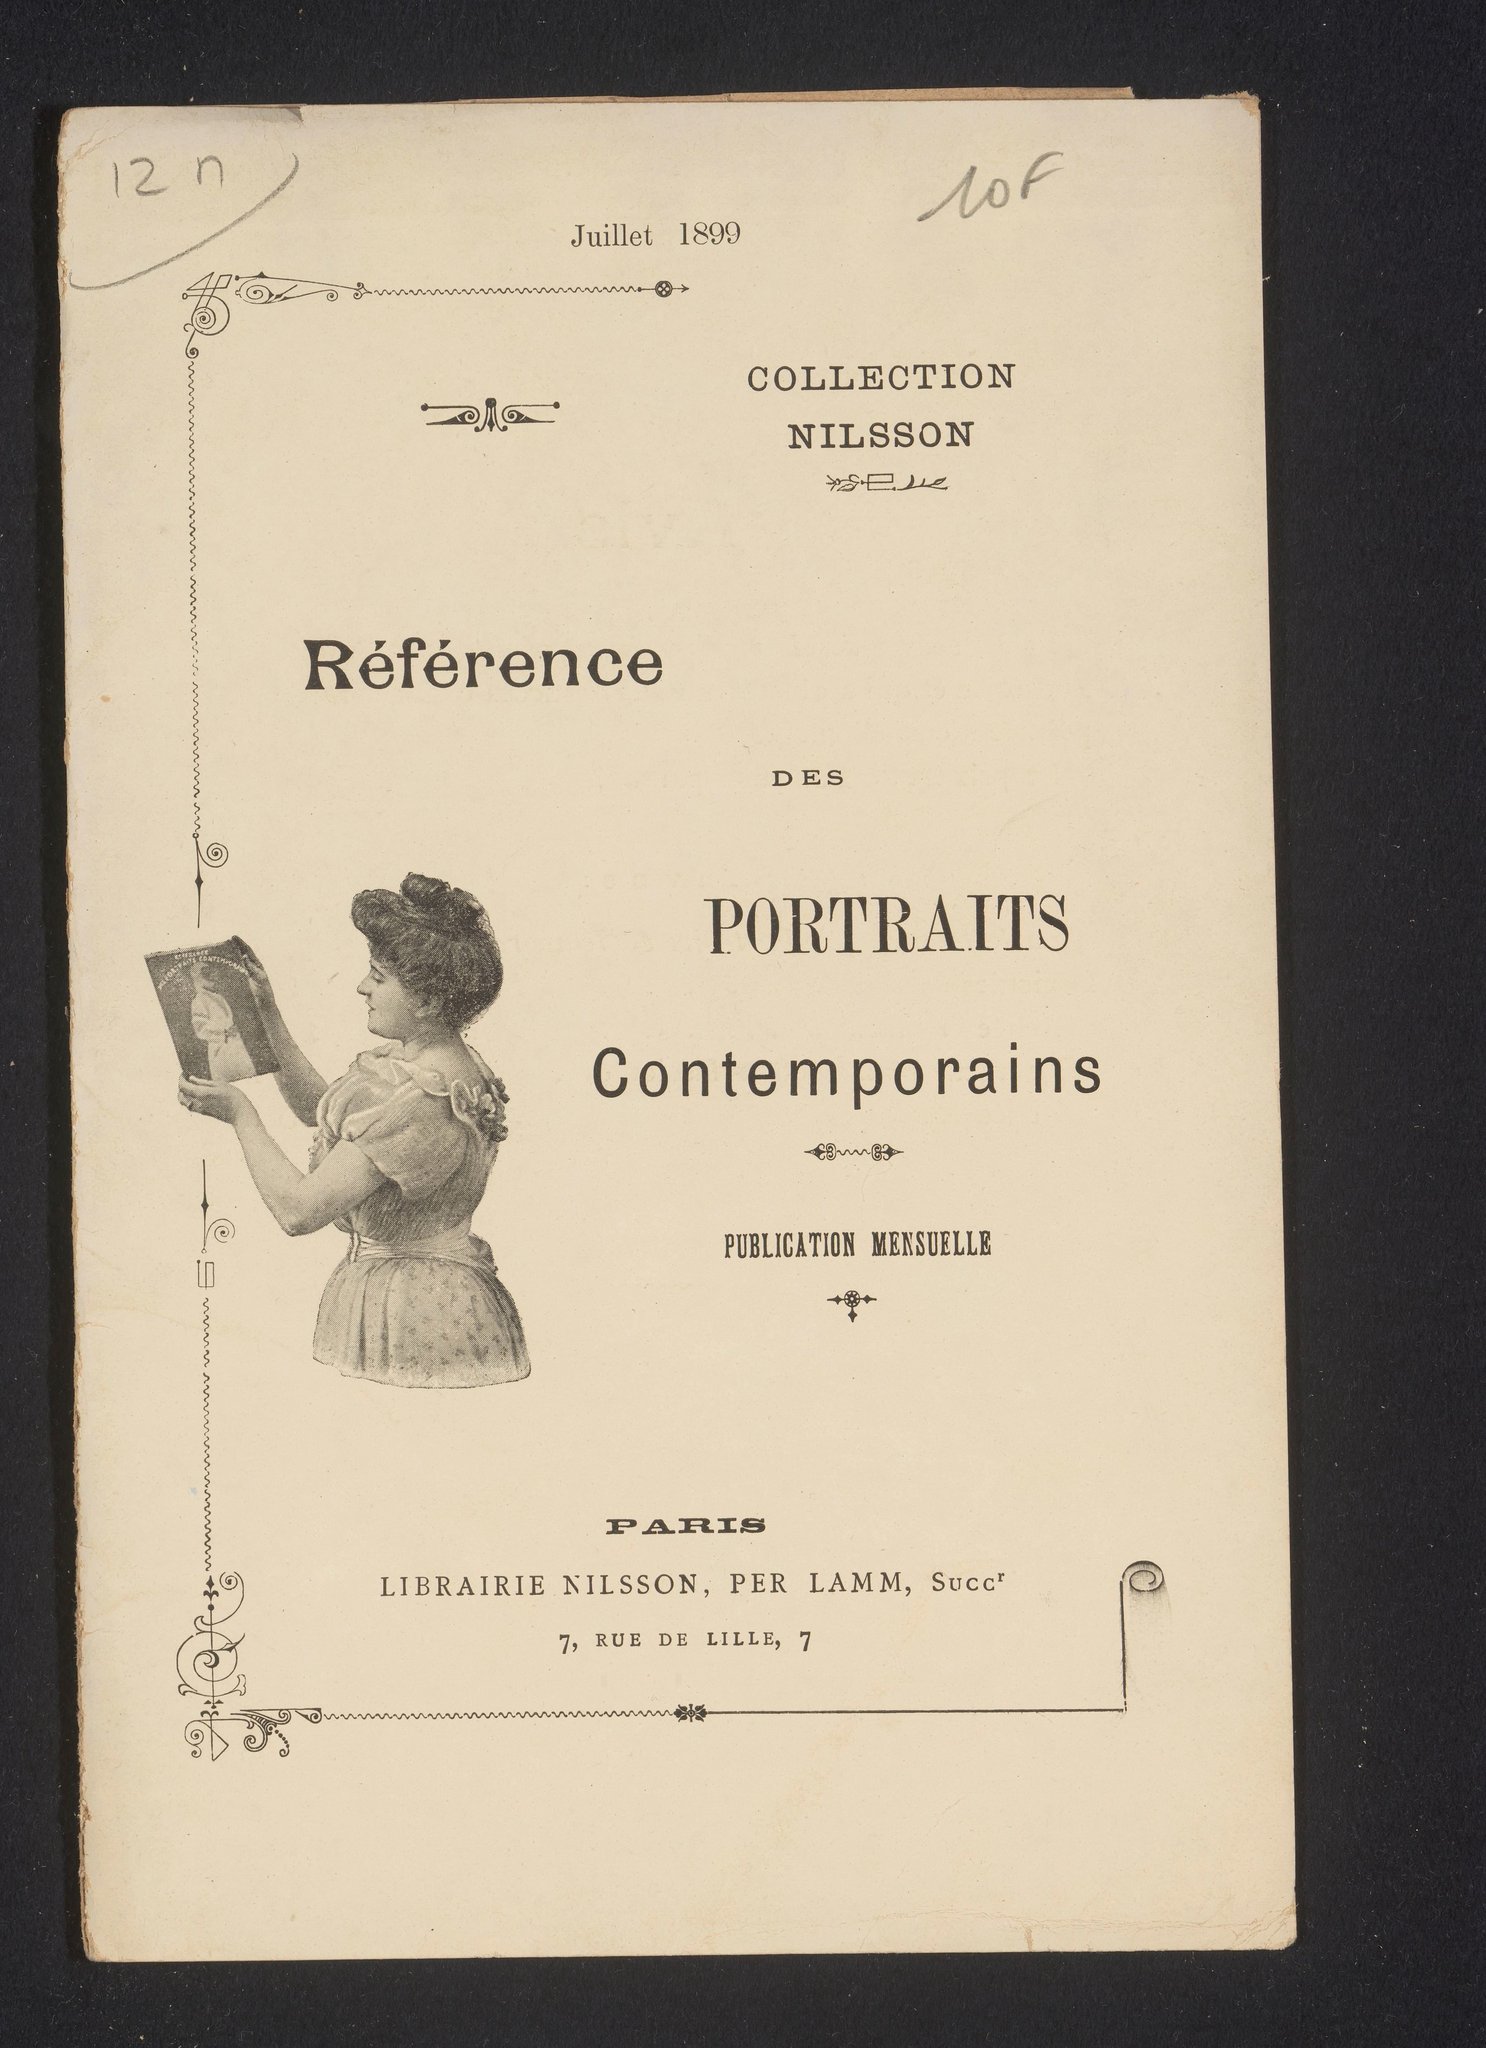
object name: magazine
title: Référence des portraits contemporains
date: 1807-1899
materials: paper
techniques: photograph, printing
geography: paris